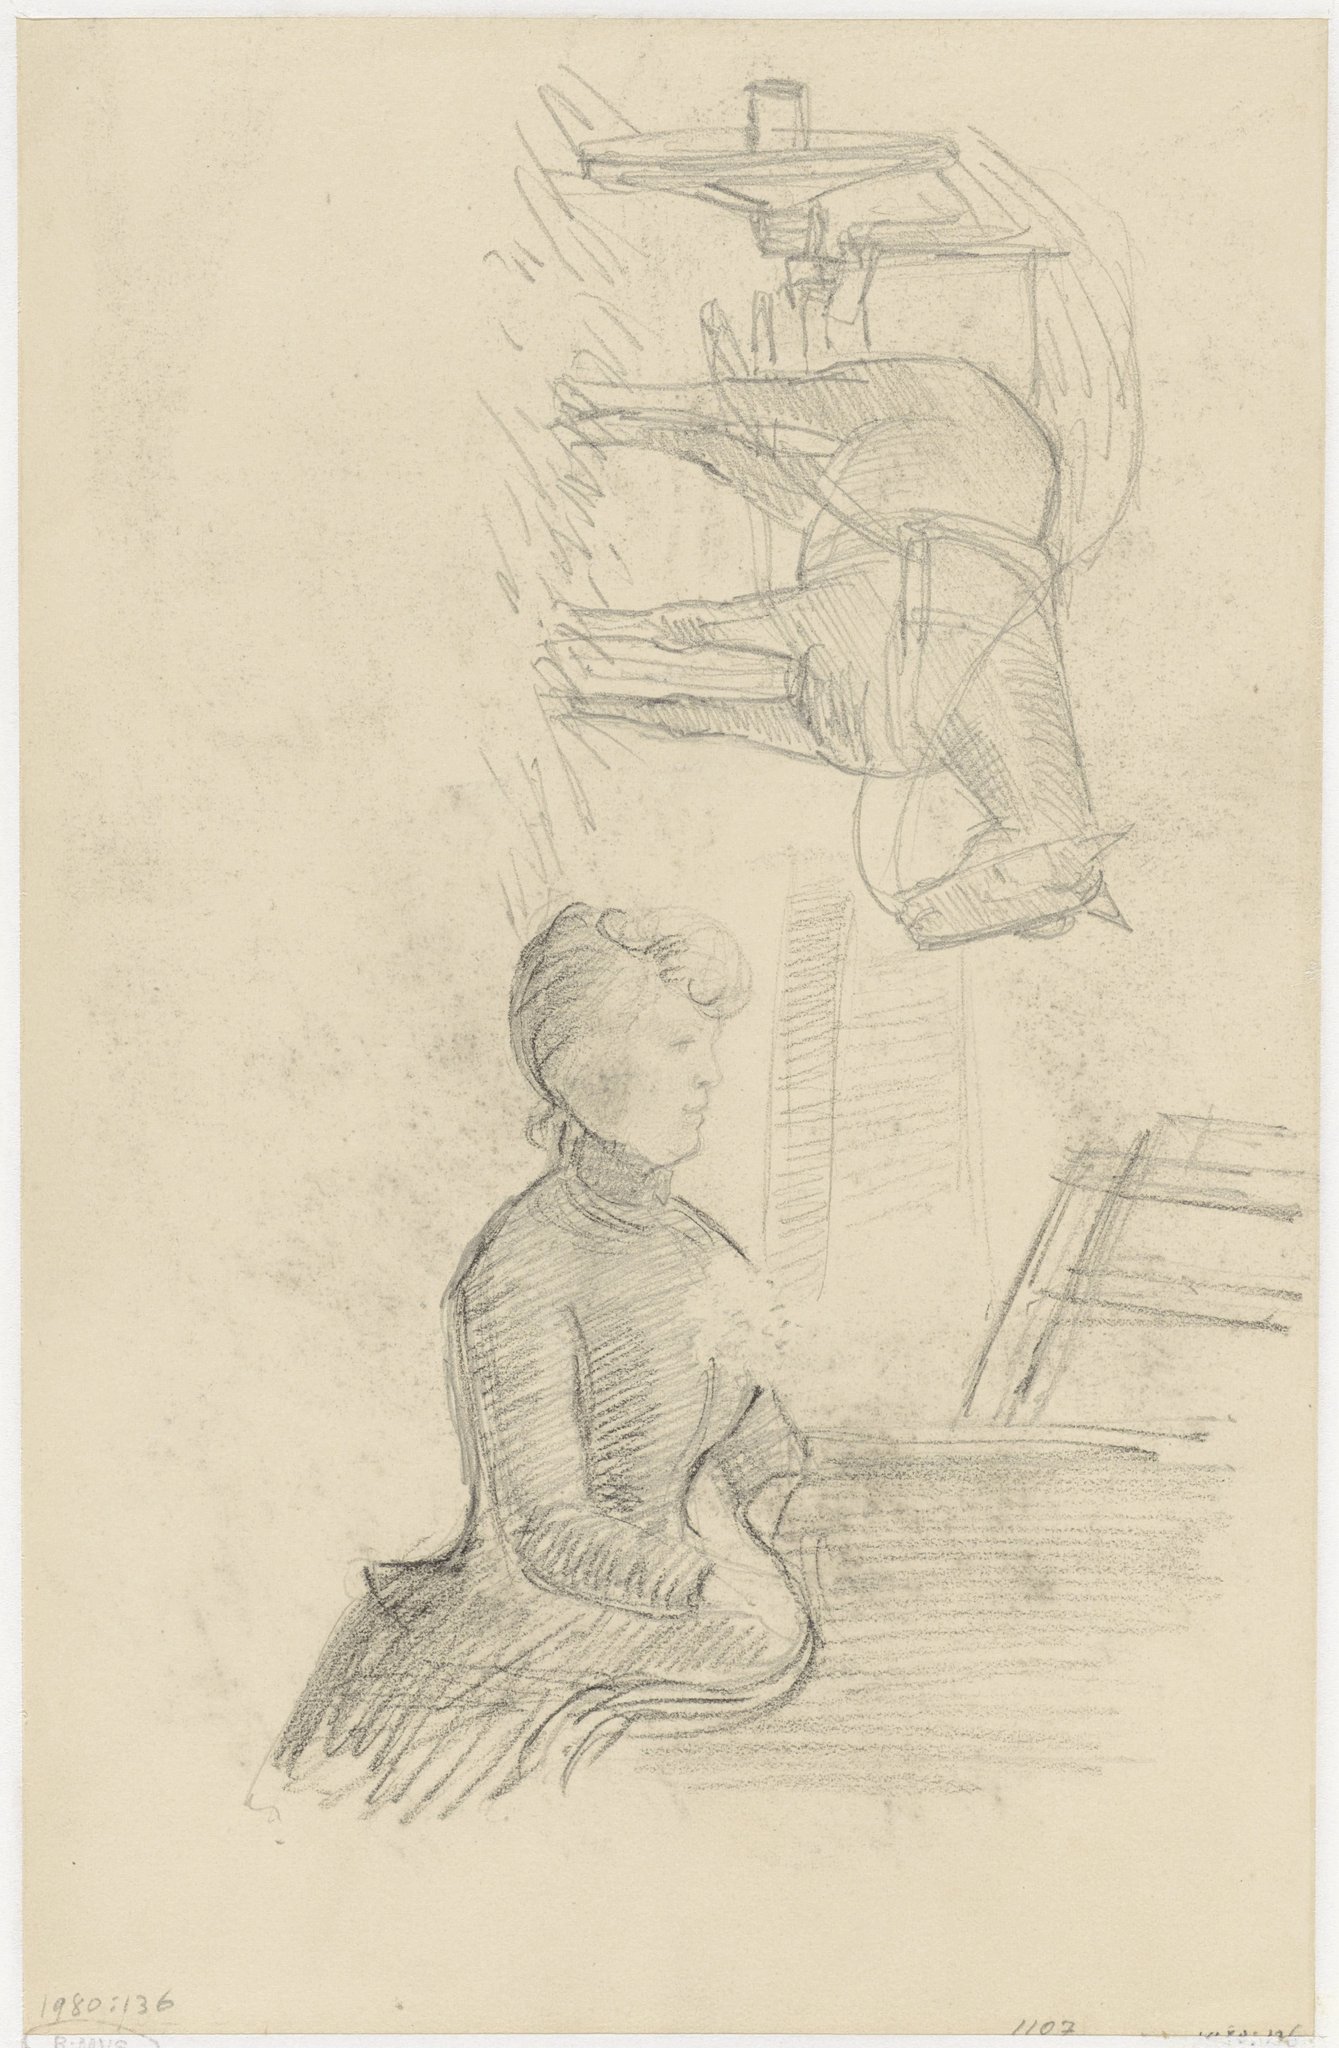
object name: drawing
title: Pianospelende vrouw en een paard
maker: jozef israëls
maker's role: draughtsman, painter, print maker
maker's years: 1824-1911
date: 1834-1911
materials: chalk, paper, pencil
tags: one person playing keyboard instrument, pianoforte, (farm) wagon, freight wagon, cart